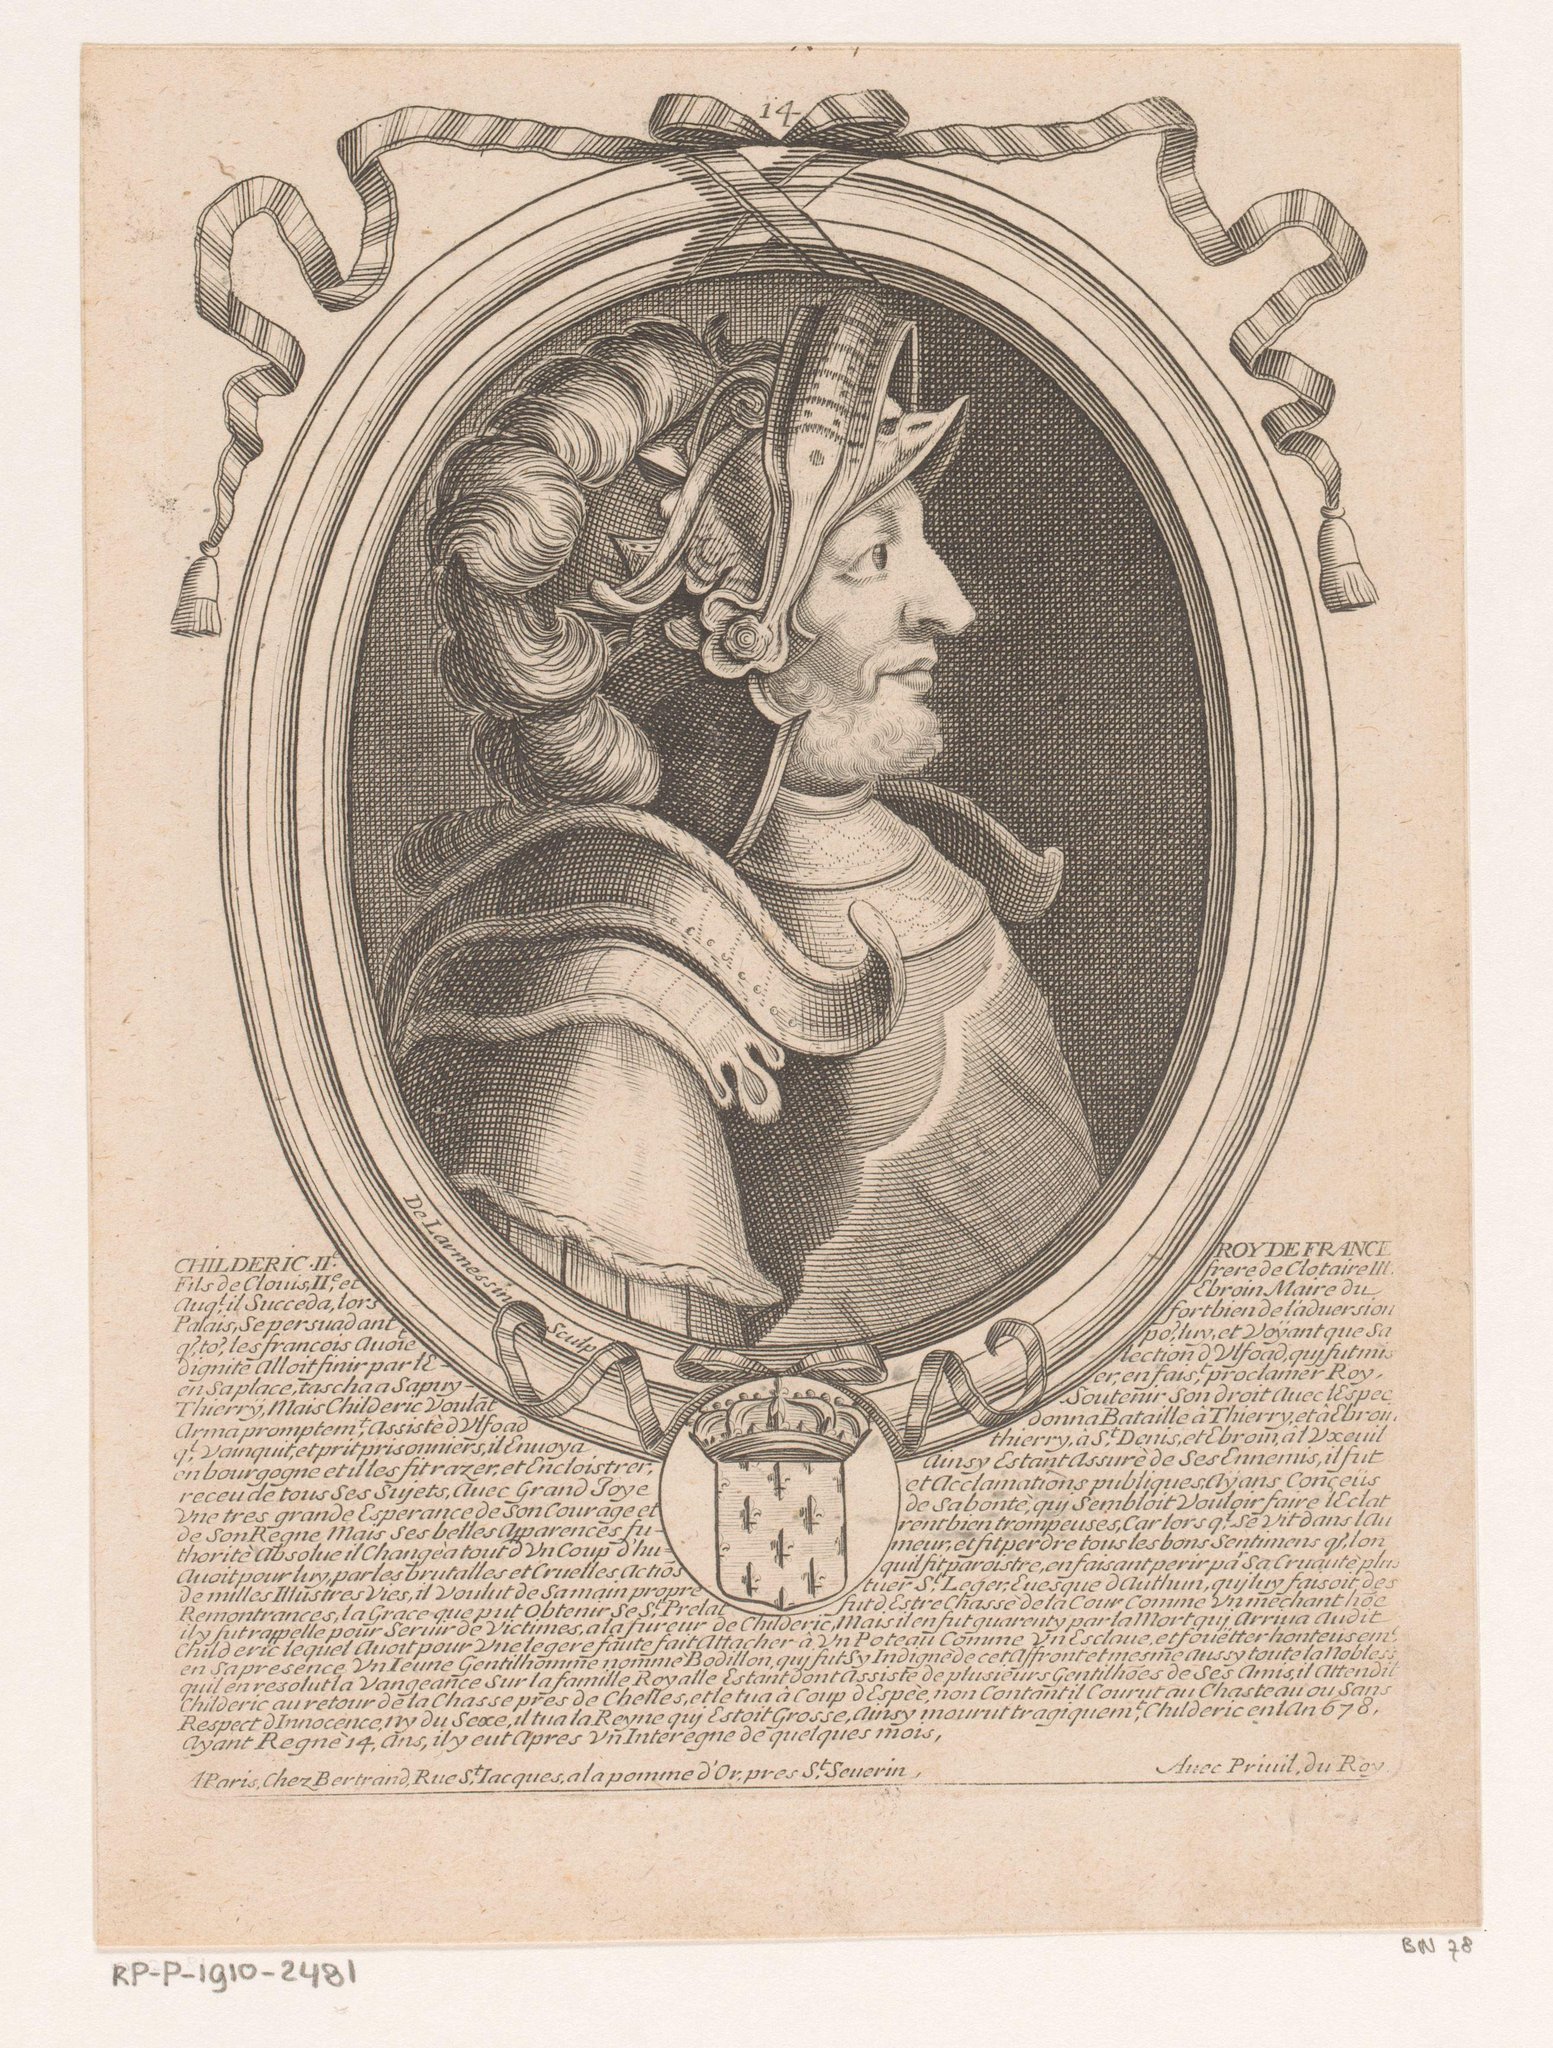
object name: print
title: Portret van Childerik II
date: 1647-1678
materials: paper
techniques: engraving, etching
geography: france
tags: historical persons, king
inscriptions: collector's mark: Lugt 2228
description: Maakt deel uit van een grootschalige serie met portretten van prominente figuren. Binnen de serie bevindt zich een sectie getiteld 'Les Augustes Représentations De tous les Roys De France depuis Pharamond Iusqu'à Louys XIIII'. De serie werd respectievelijk uitgegeven door Pierre Bertrand, door zijn weduwe en door De Larmessin zelf.